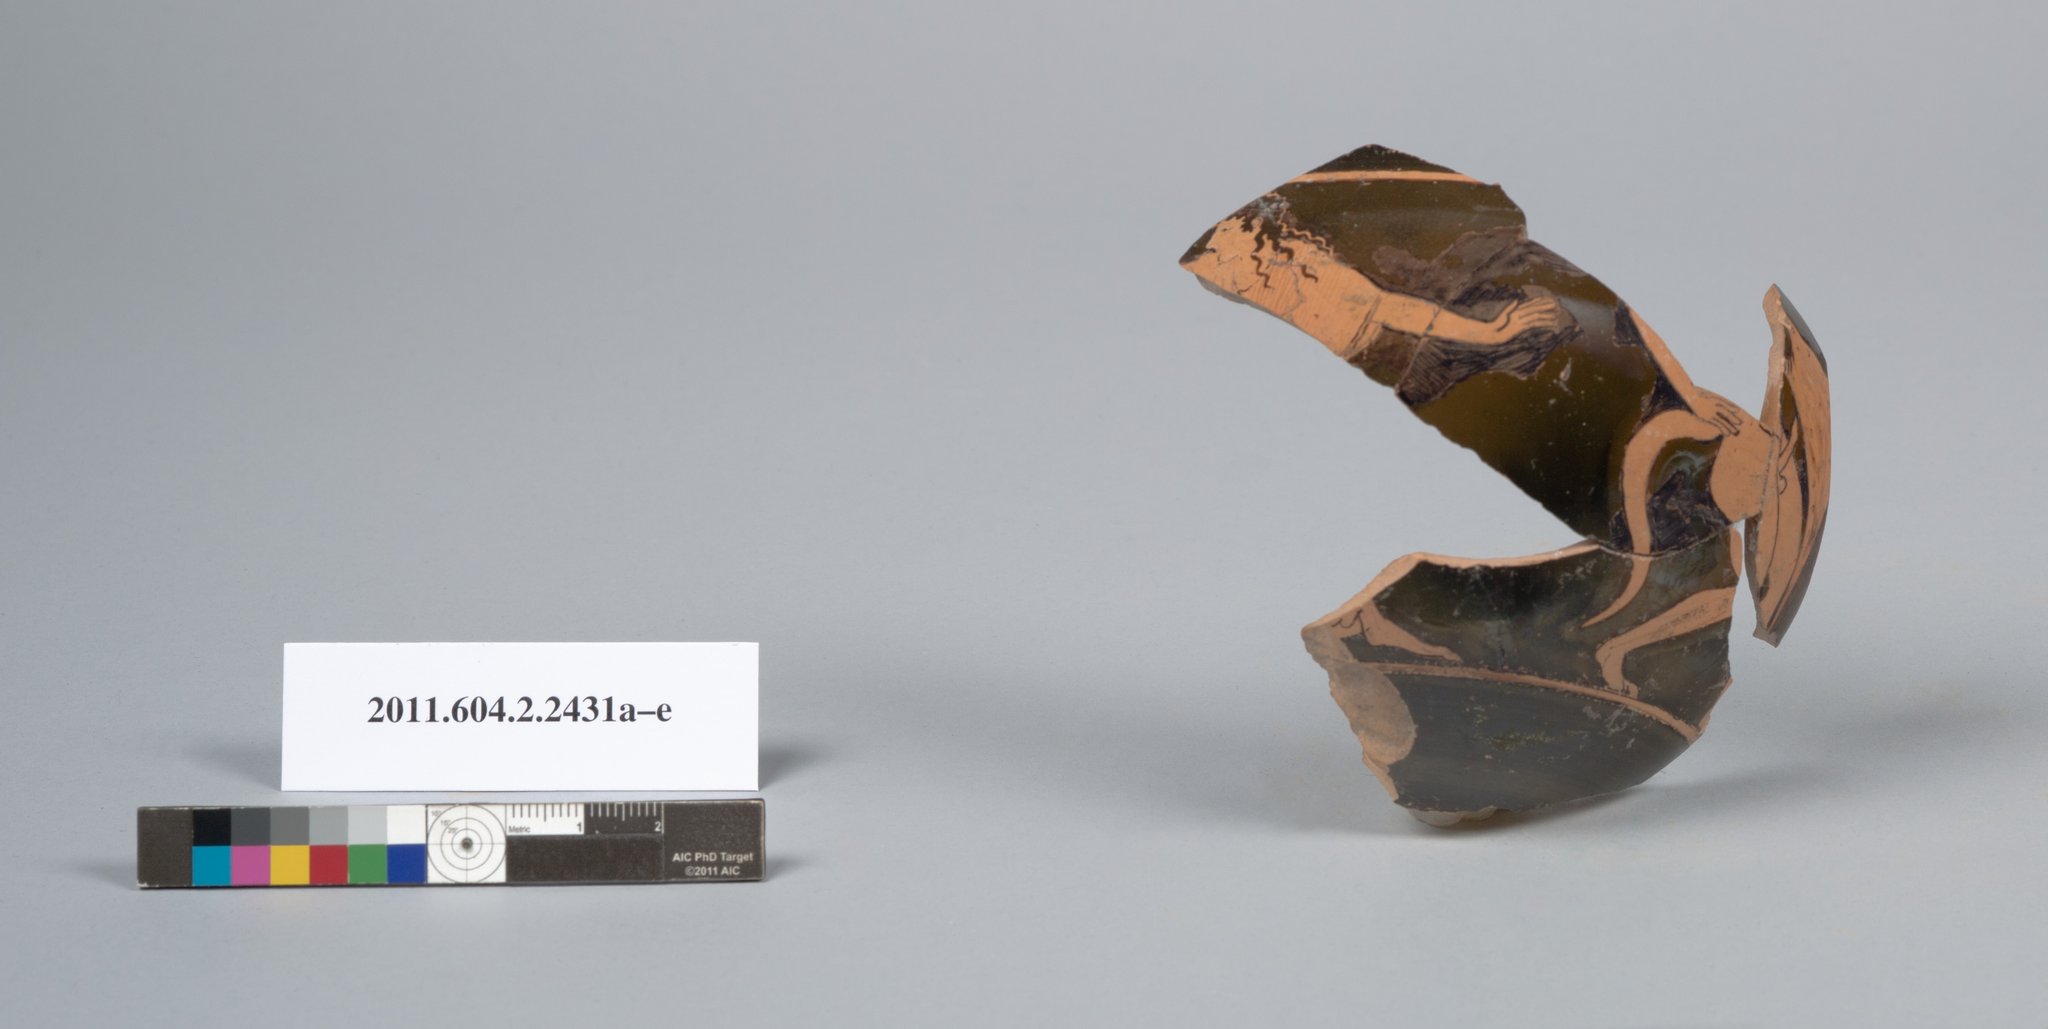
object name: mastoid fragment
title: Terracotta fragments of a mastoid?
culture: greek, attic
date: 520-510 BCE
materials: terracotta